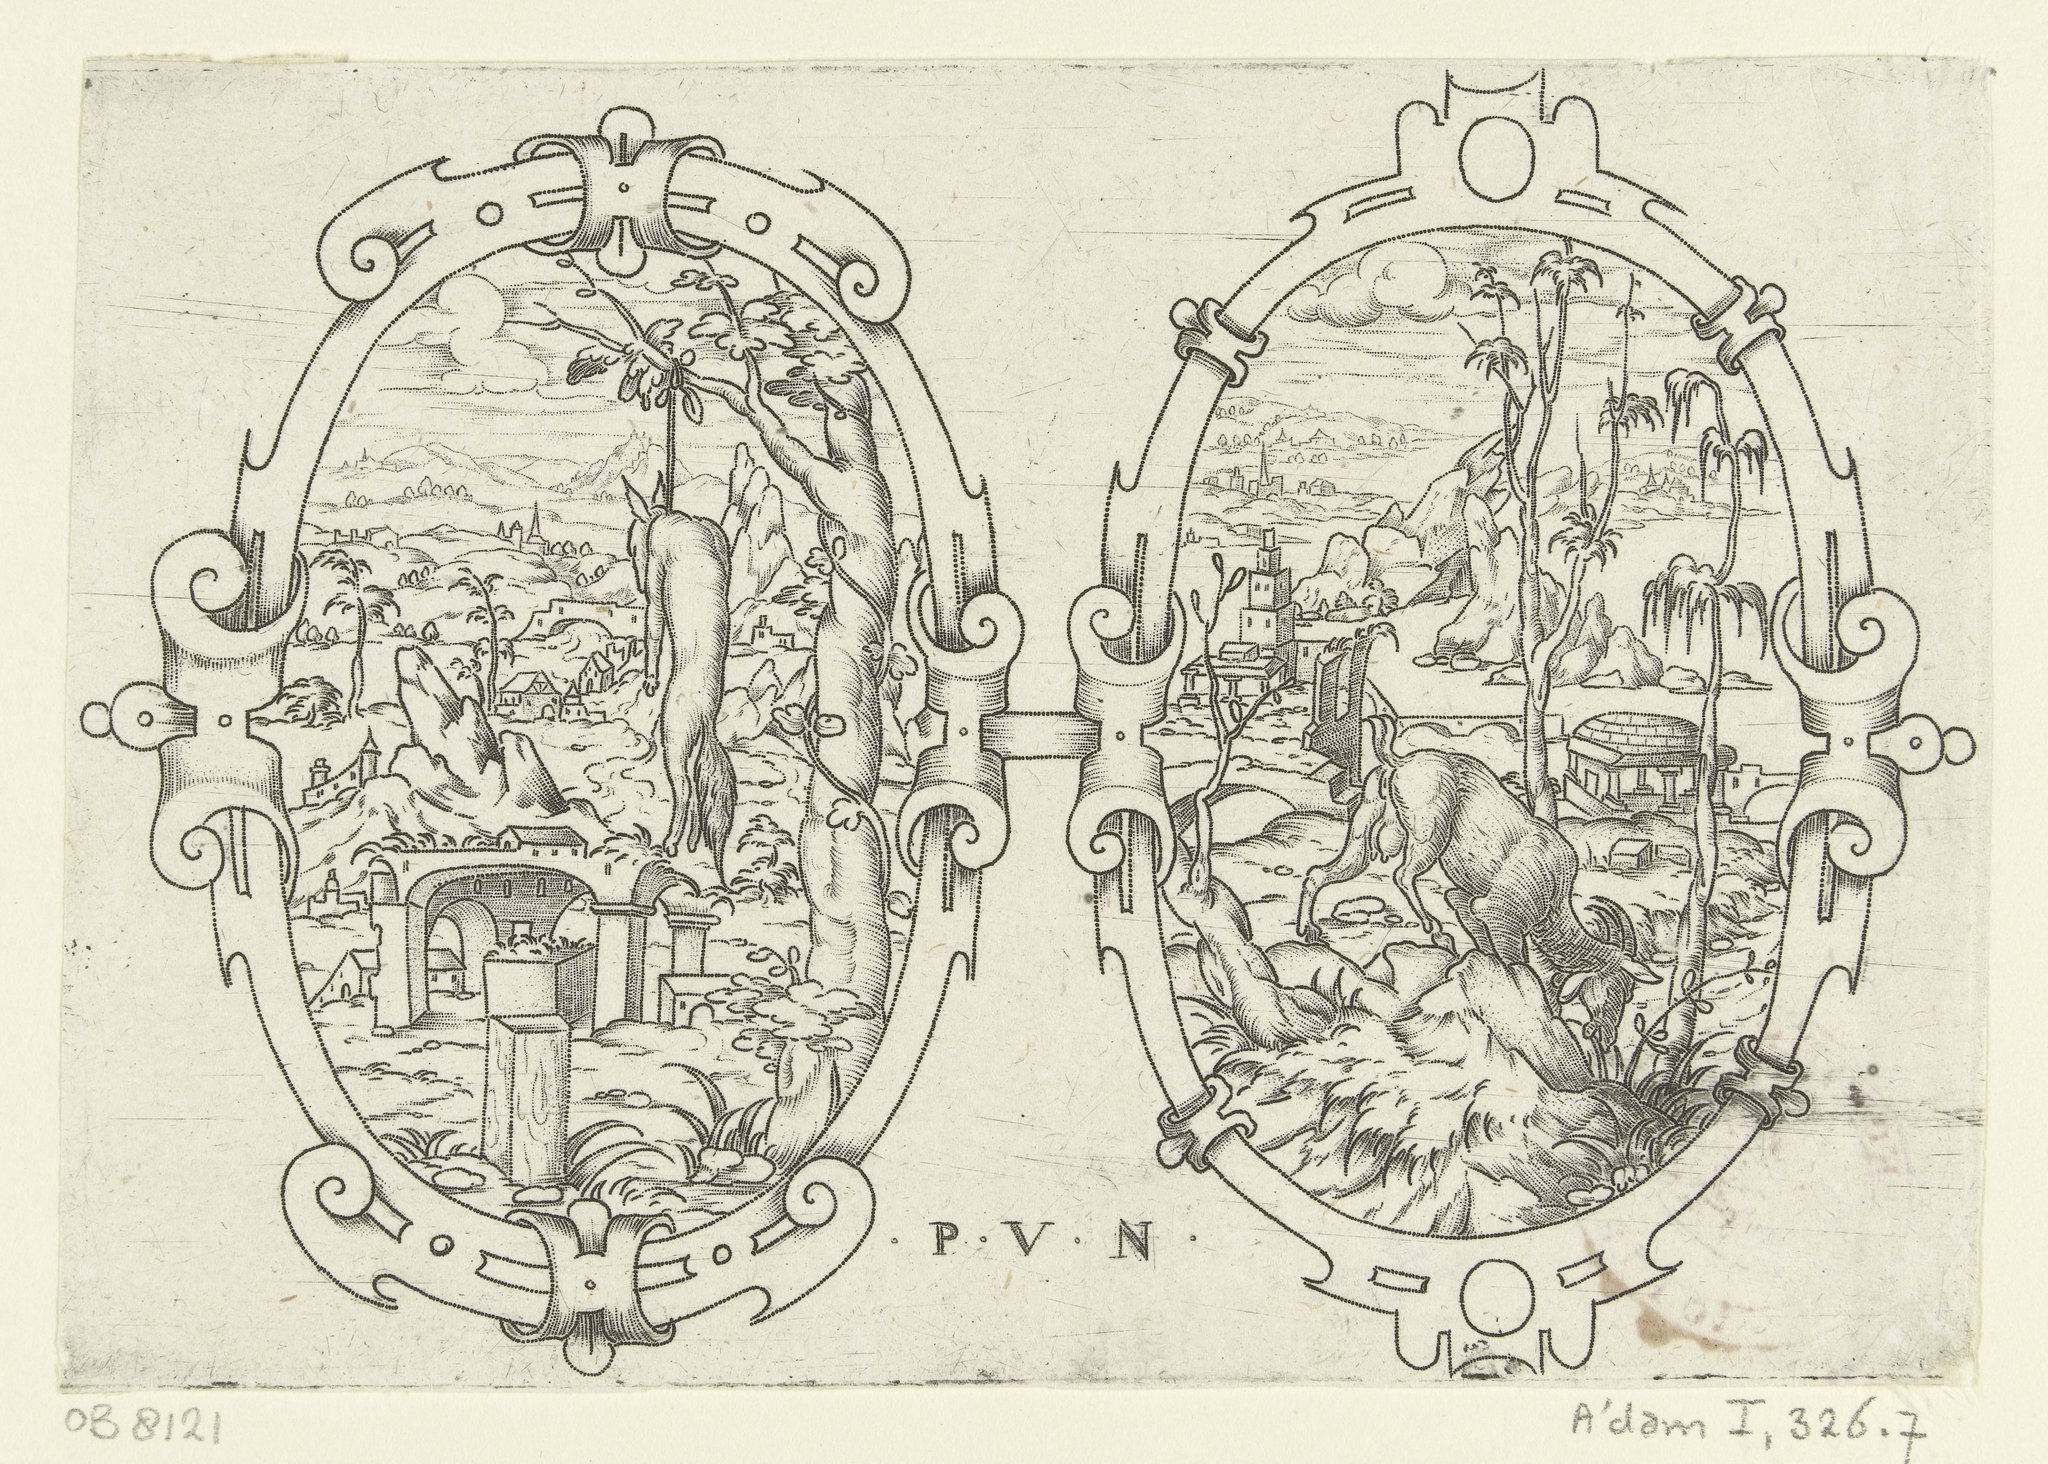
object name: ornament print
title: Twee ovalen, links met een vos die in een strop aan een boom hangt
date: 1600-1699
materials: paper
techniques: engraving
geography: germany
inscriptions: collector's mark: Lugt 240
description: In het ovaal rechts staat een geit. Uit serie van 12 bladen.